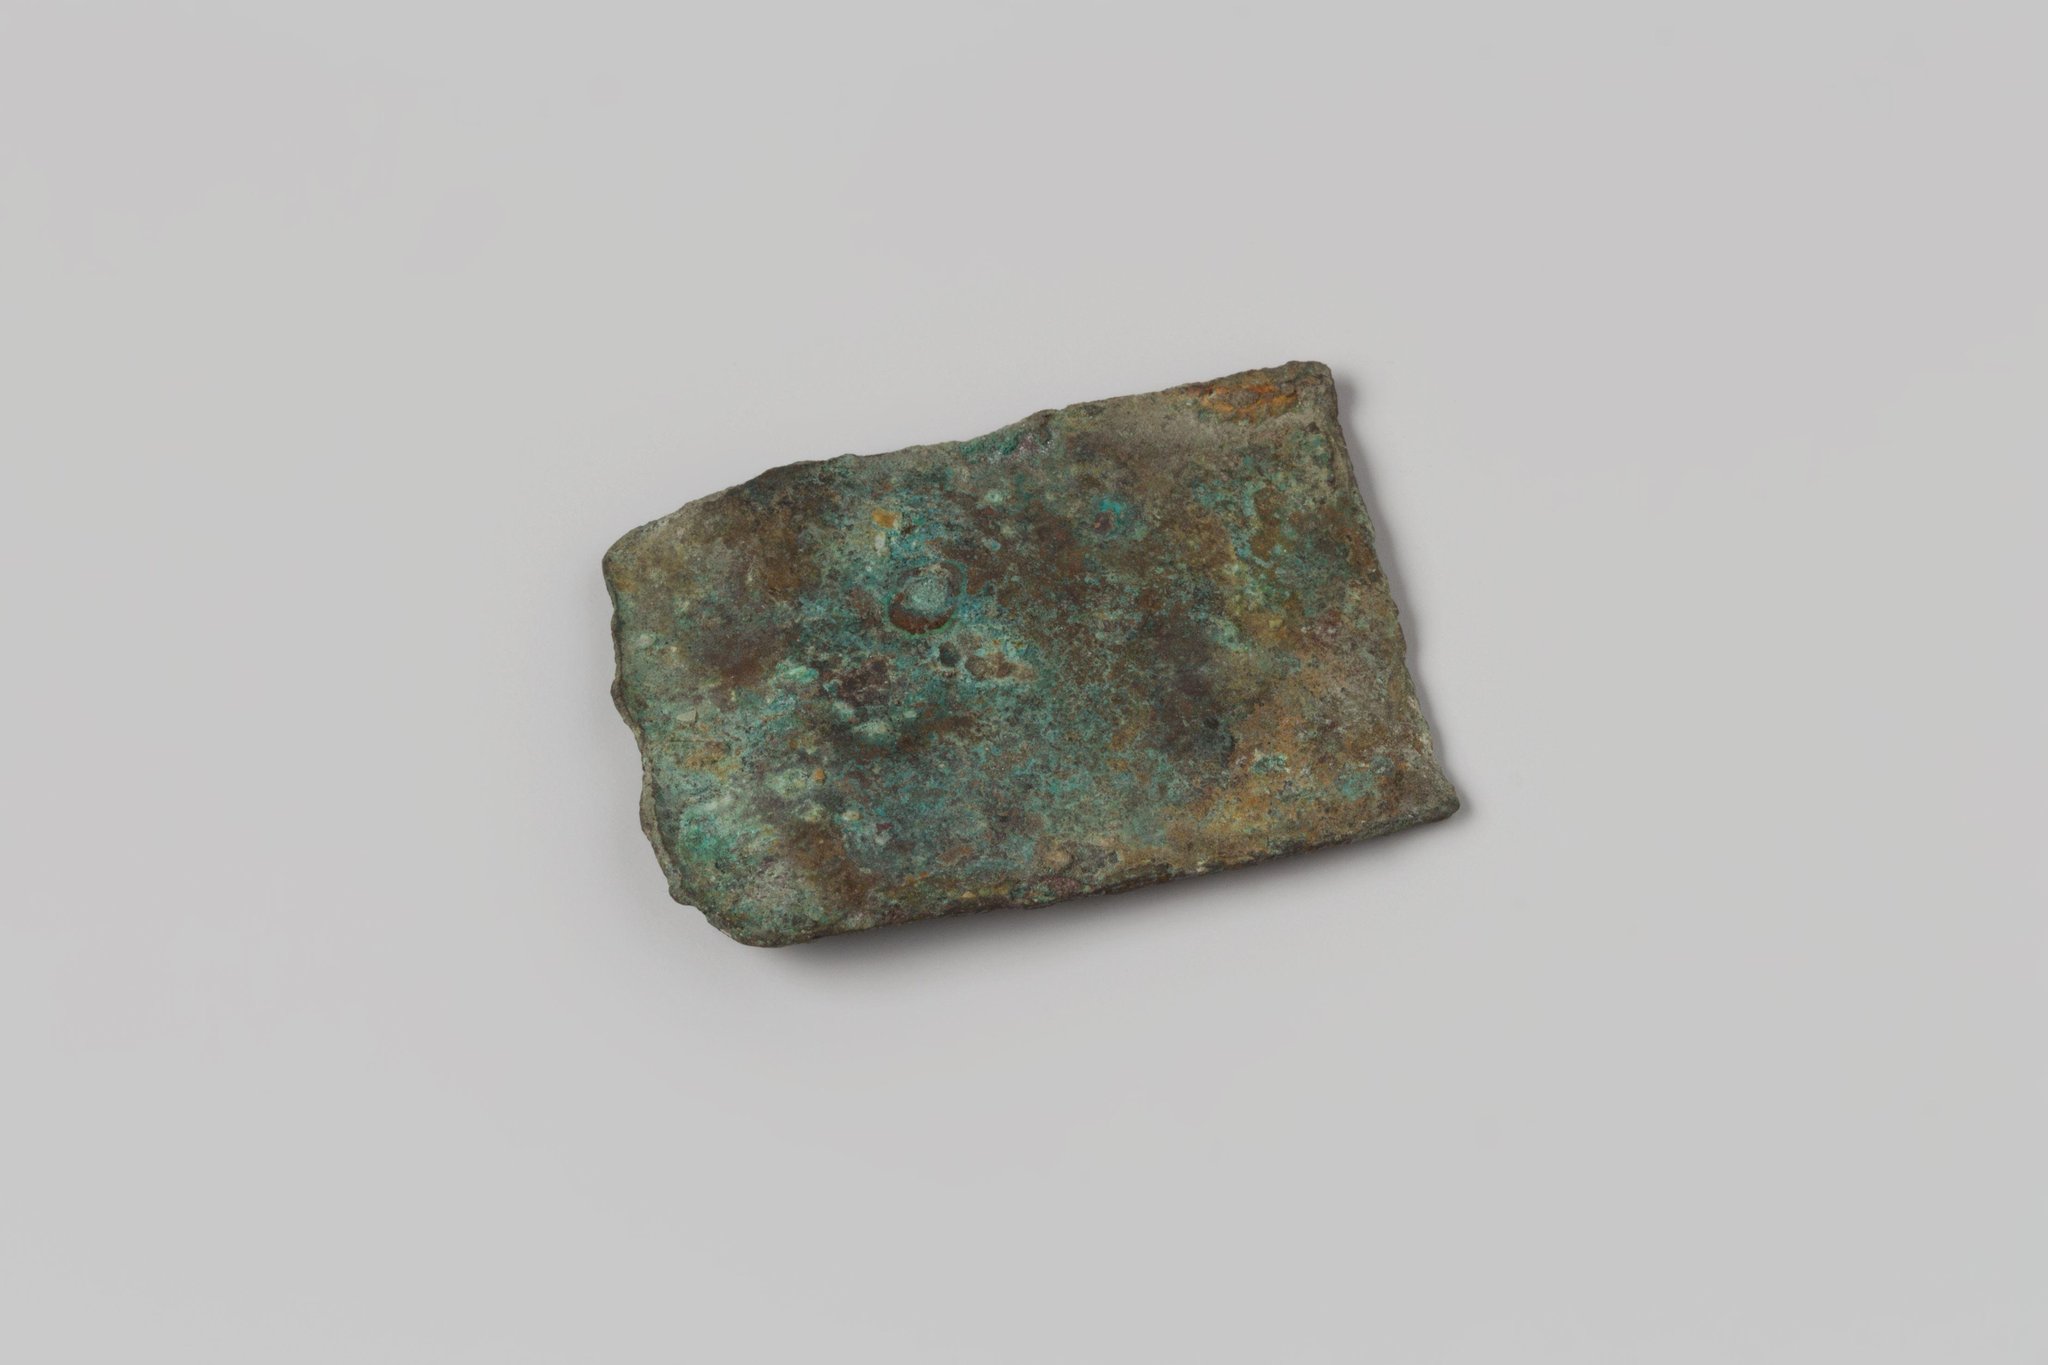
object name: scheepswrakvondst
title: Fragment van koper uit het wrak van de Oost-Indiëvaarder Hollandia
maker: Anonymous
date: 1700-1743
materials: copper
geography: netherlands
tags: verenigde oostindische compagnie, hollandia (schip), annet